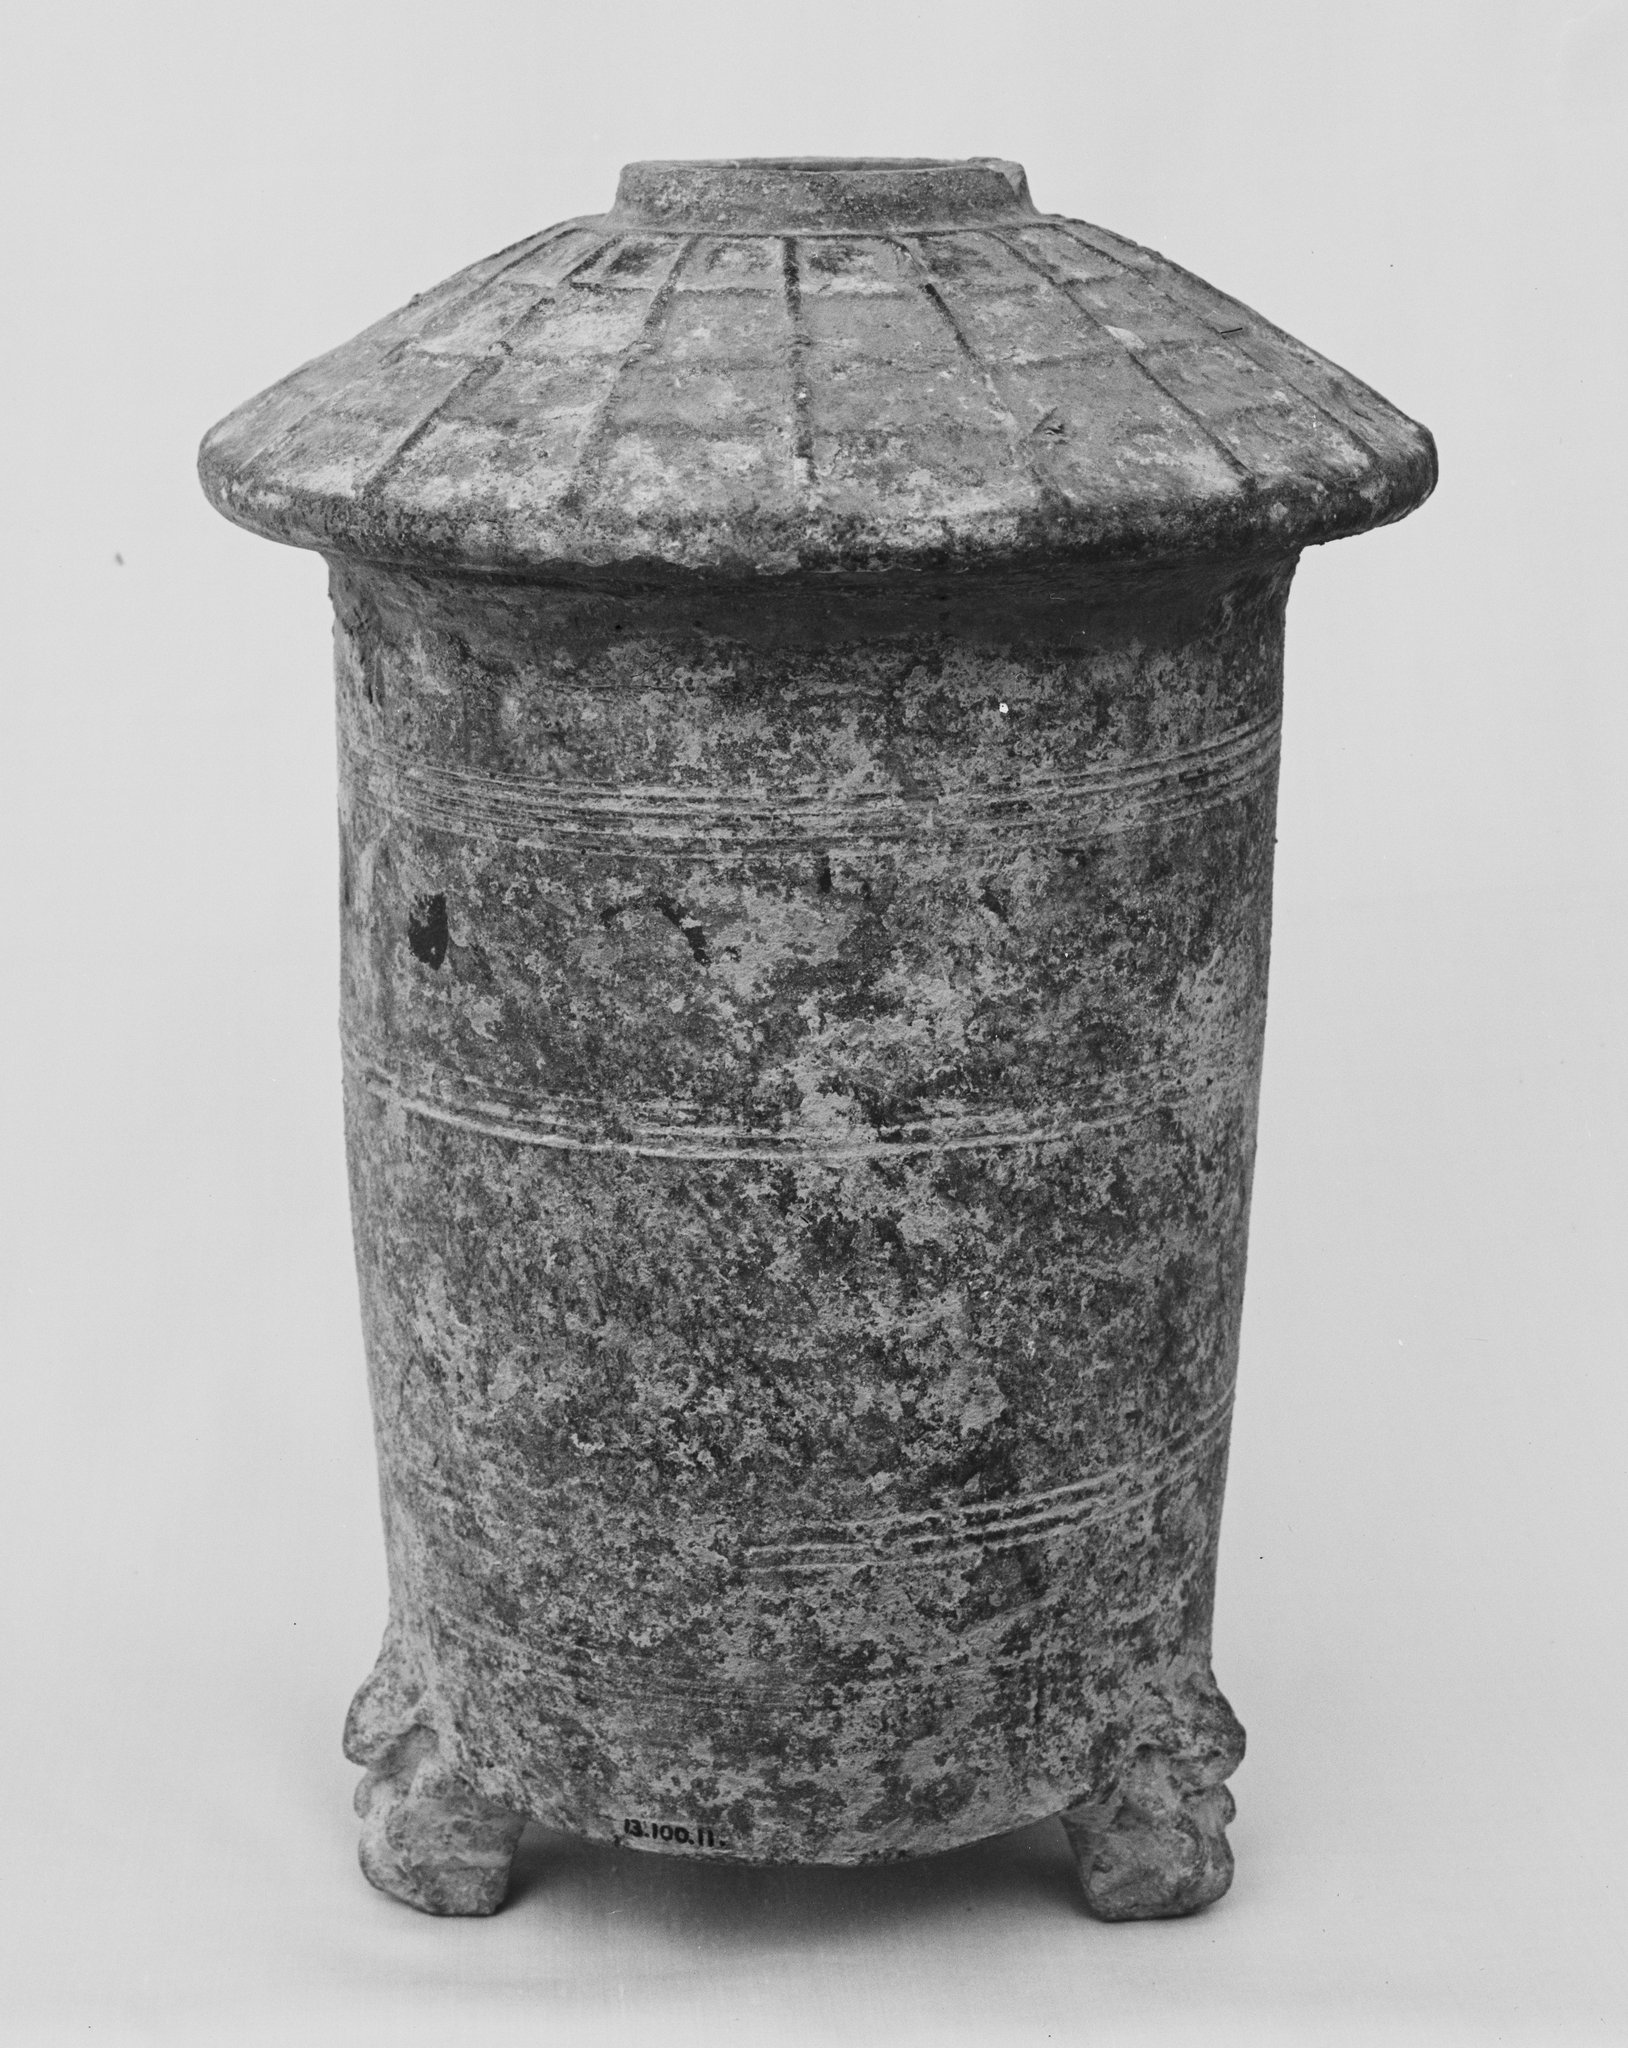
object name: model of farm building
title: Granary Tower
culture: chinese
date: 1-233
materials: earthenware, glaze